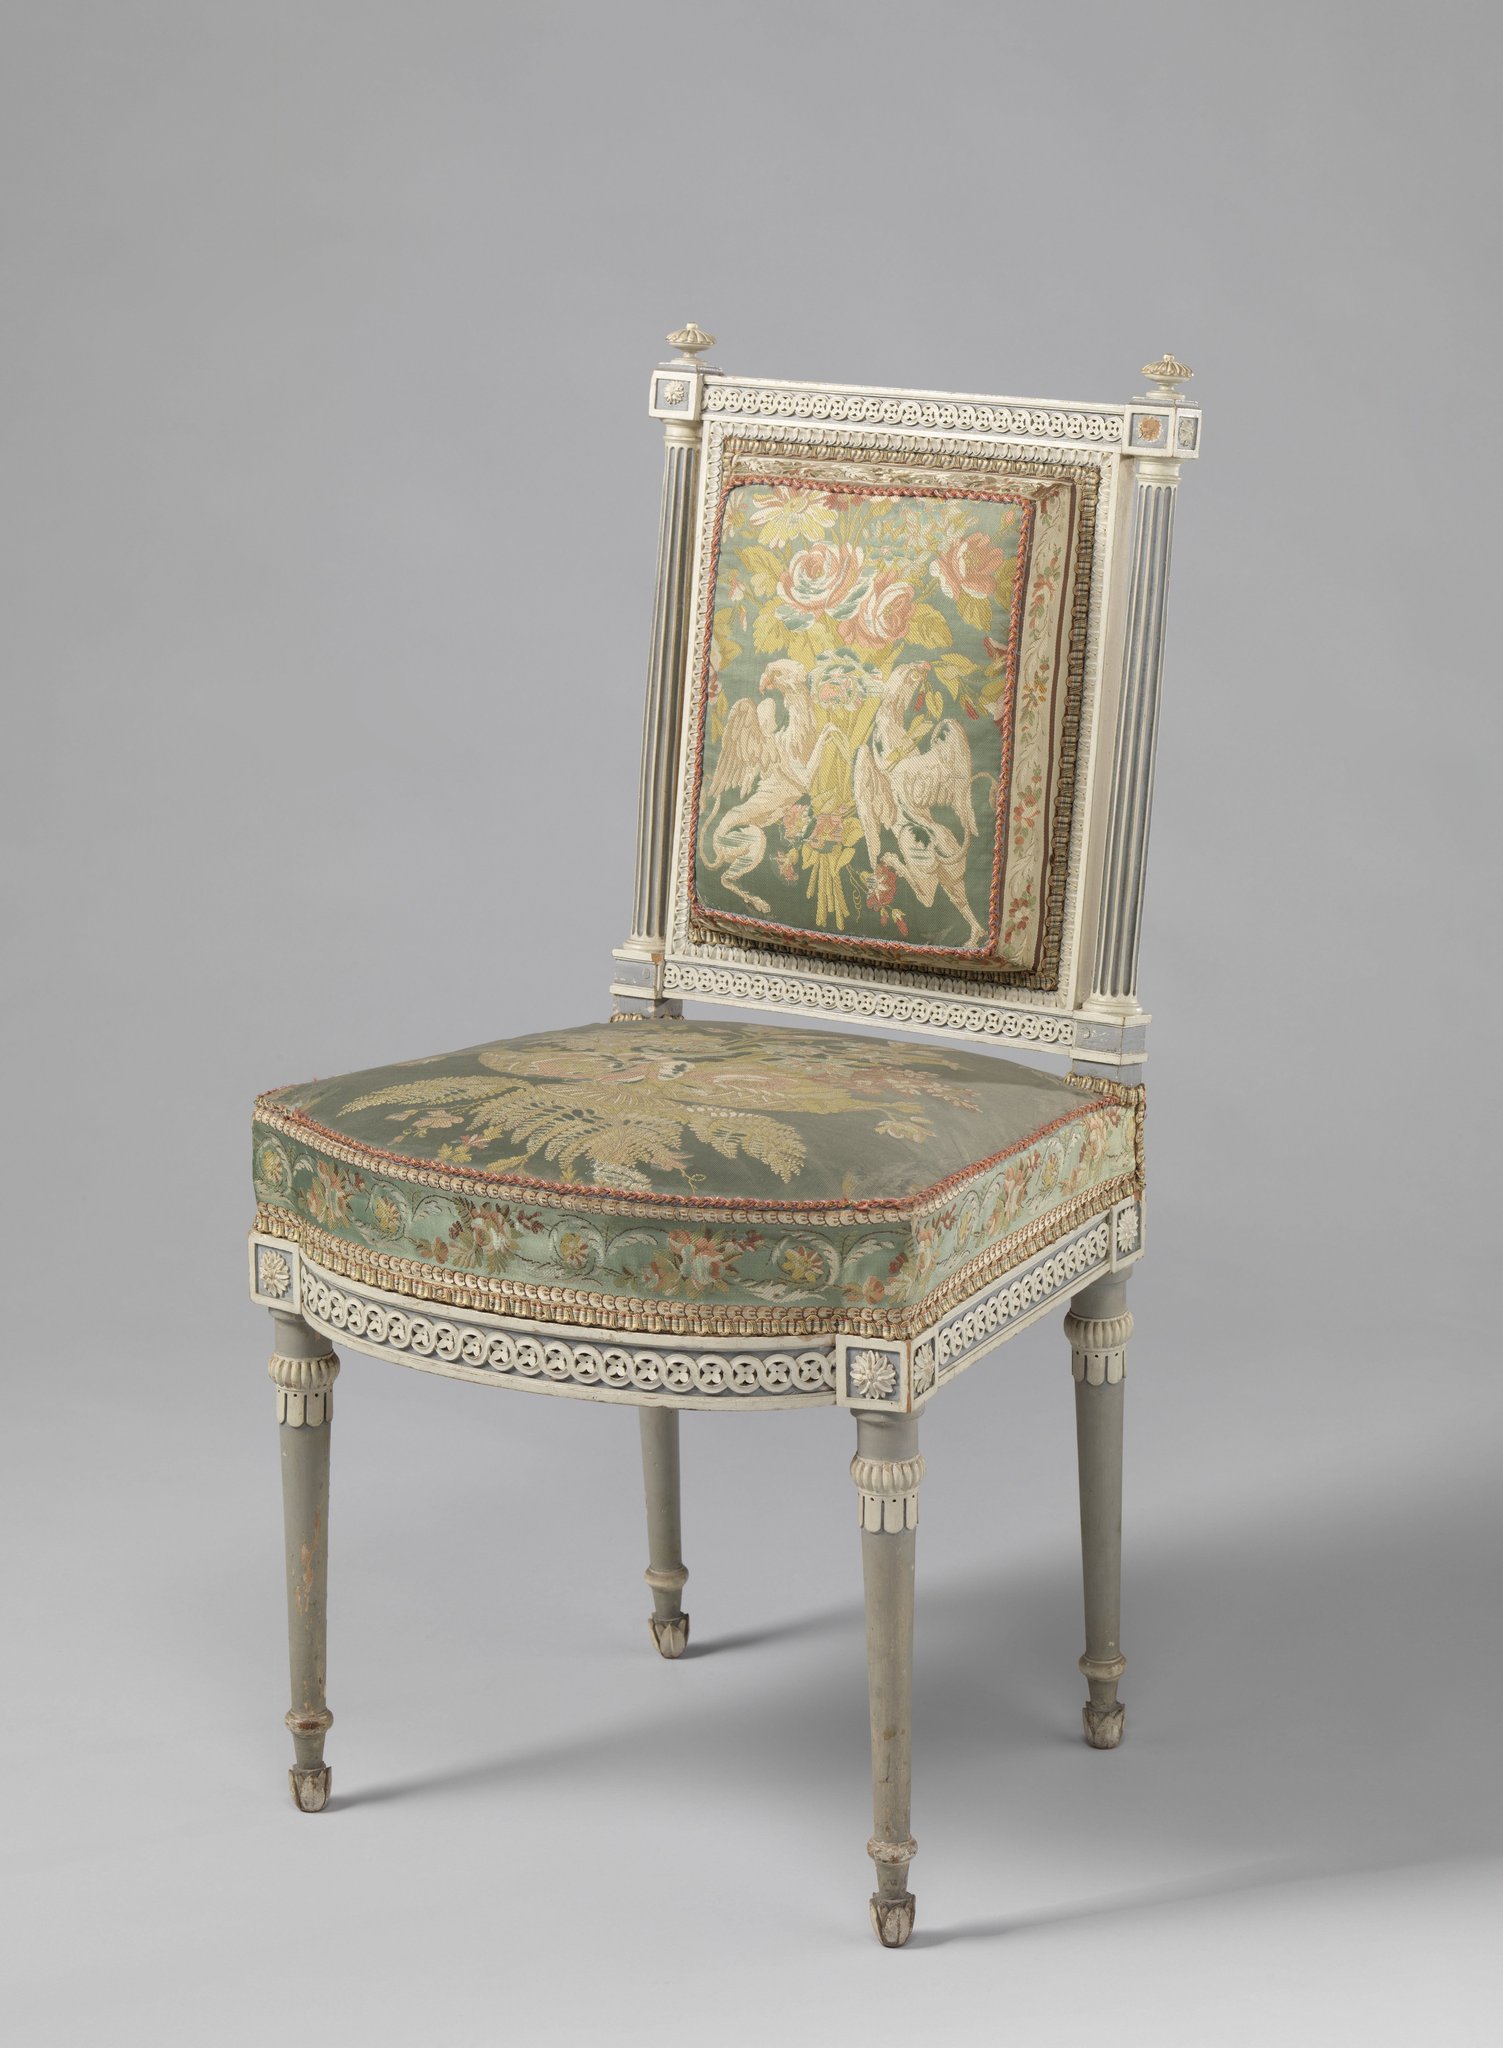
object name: chair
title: Stoel Kops-ameublement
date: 1793-1795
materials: wood, paint, silk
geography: netherlands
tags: haarlem, griffin (lion/eagle); 'griffo' (ripa), flowers ~ ornament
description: Beklede stoel, deel uitmakend van het Kops-ameublement, van wit en blauwgrijs beschilderd beukenhout en rustend op conische poten. De zitregels en dorpels van het rugraam, met Toscaanse gecanneleerde zuilen als rugstijlen, vertonen gestoken vlechtband met rozetten. Afwerking met rozetten en acanthusbladeren. De bekleding vertoont op lichtblauwe satijnen grond florale motieven, op de rug gehouden door griffioenen. Besteld voor het pand Nieuwe Gracht 74, Haarlem. Zie: BK-15615-a/p, BK-15614, BK-15616-a/b.